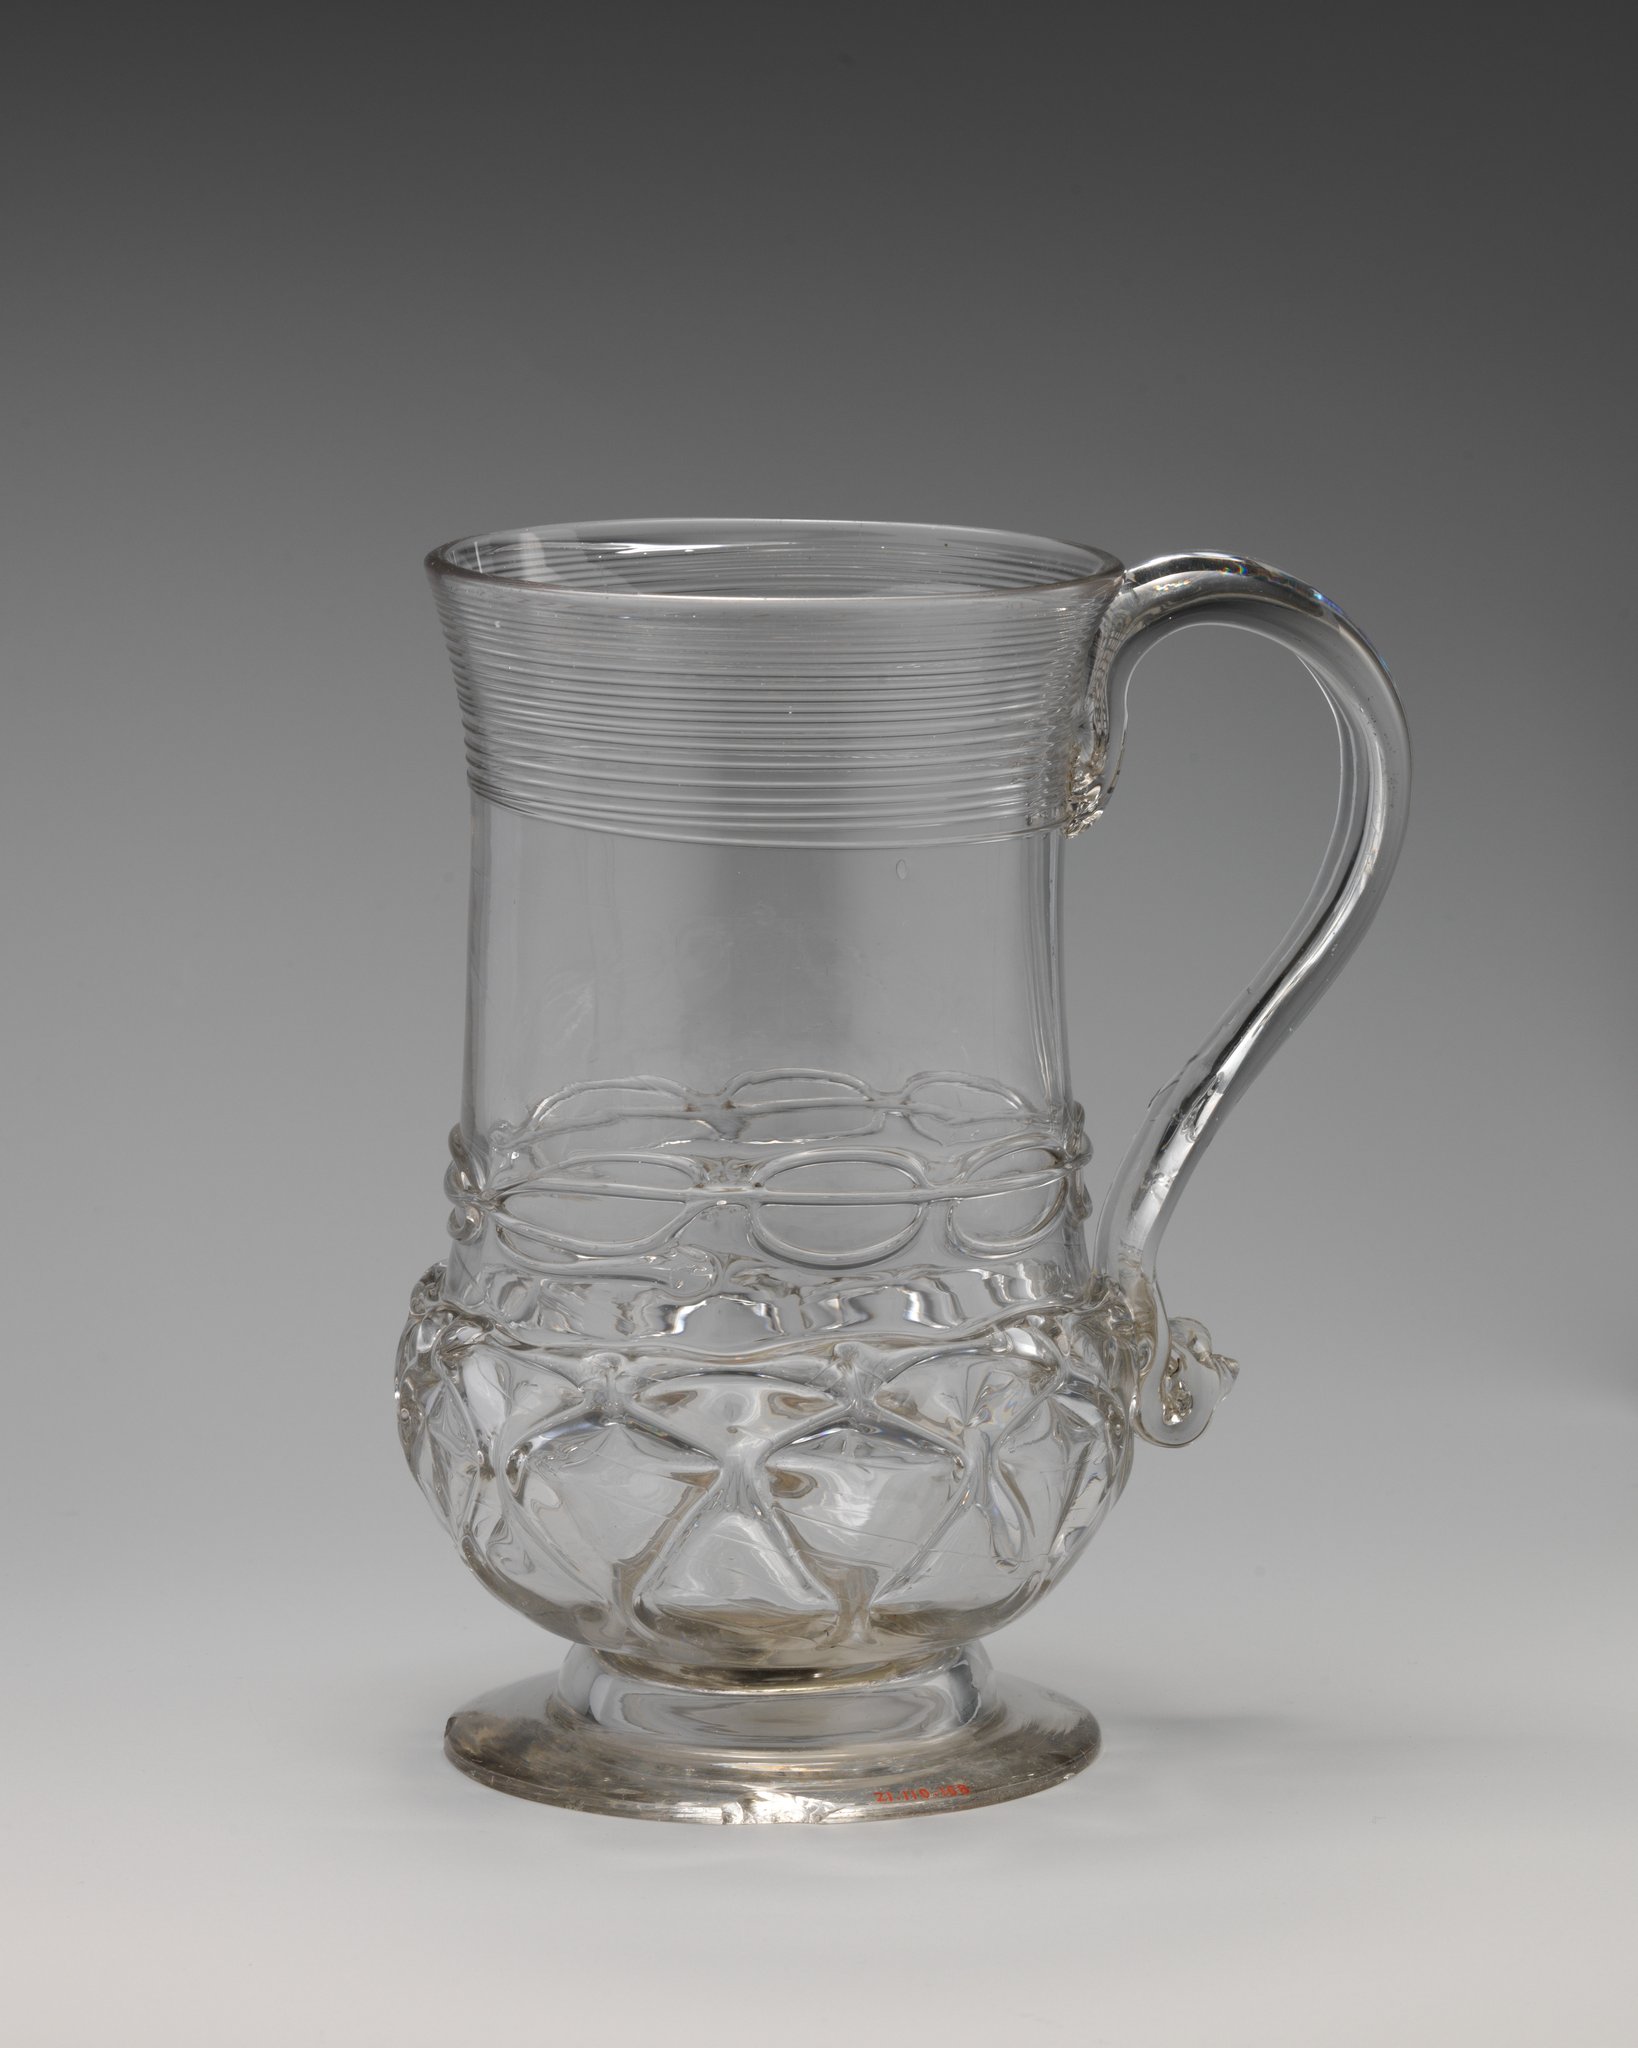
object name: mug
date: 1750-1800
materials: glass